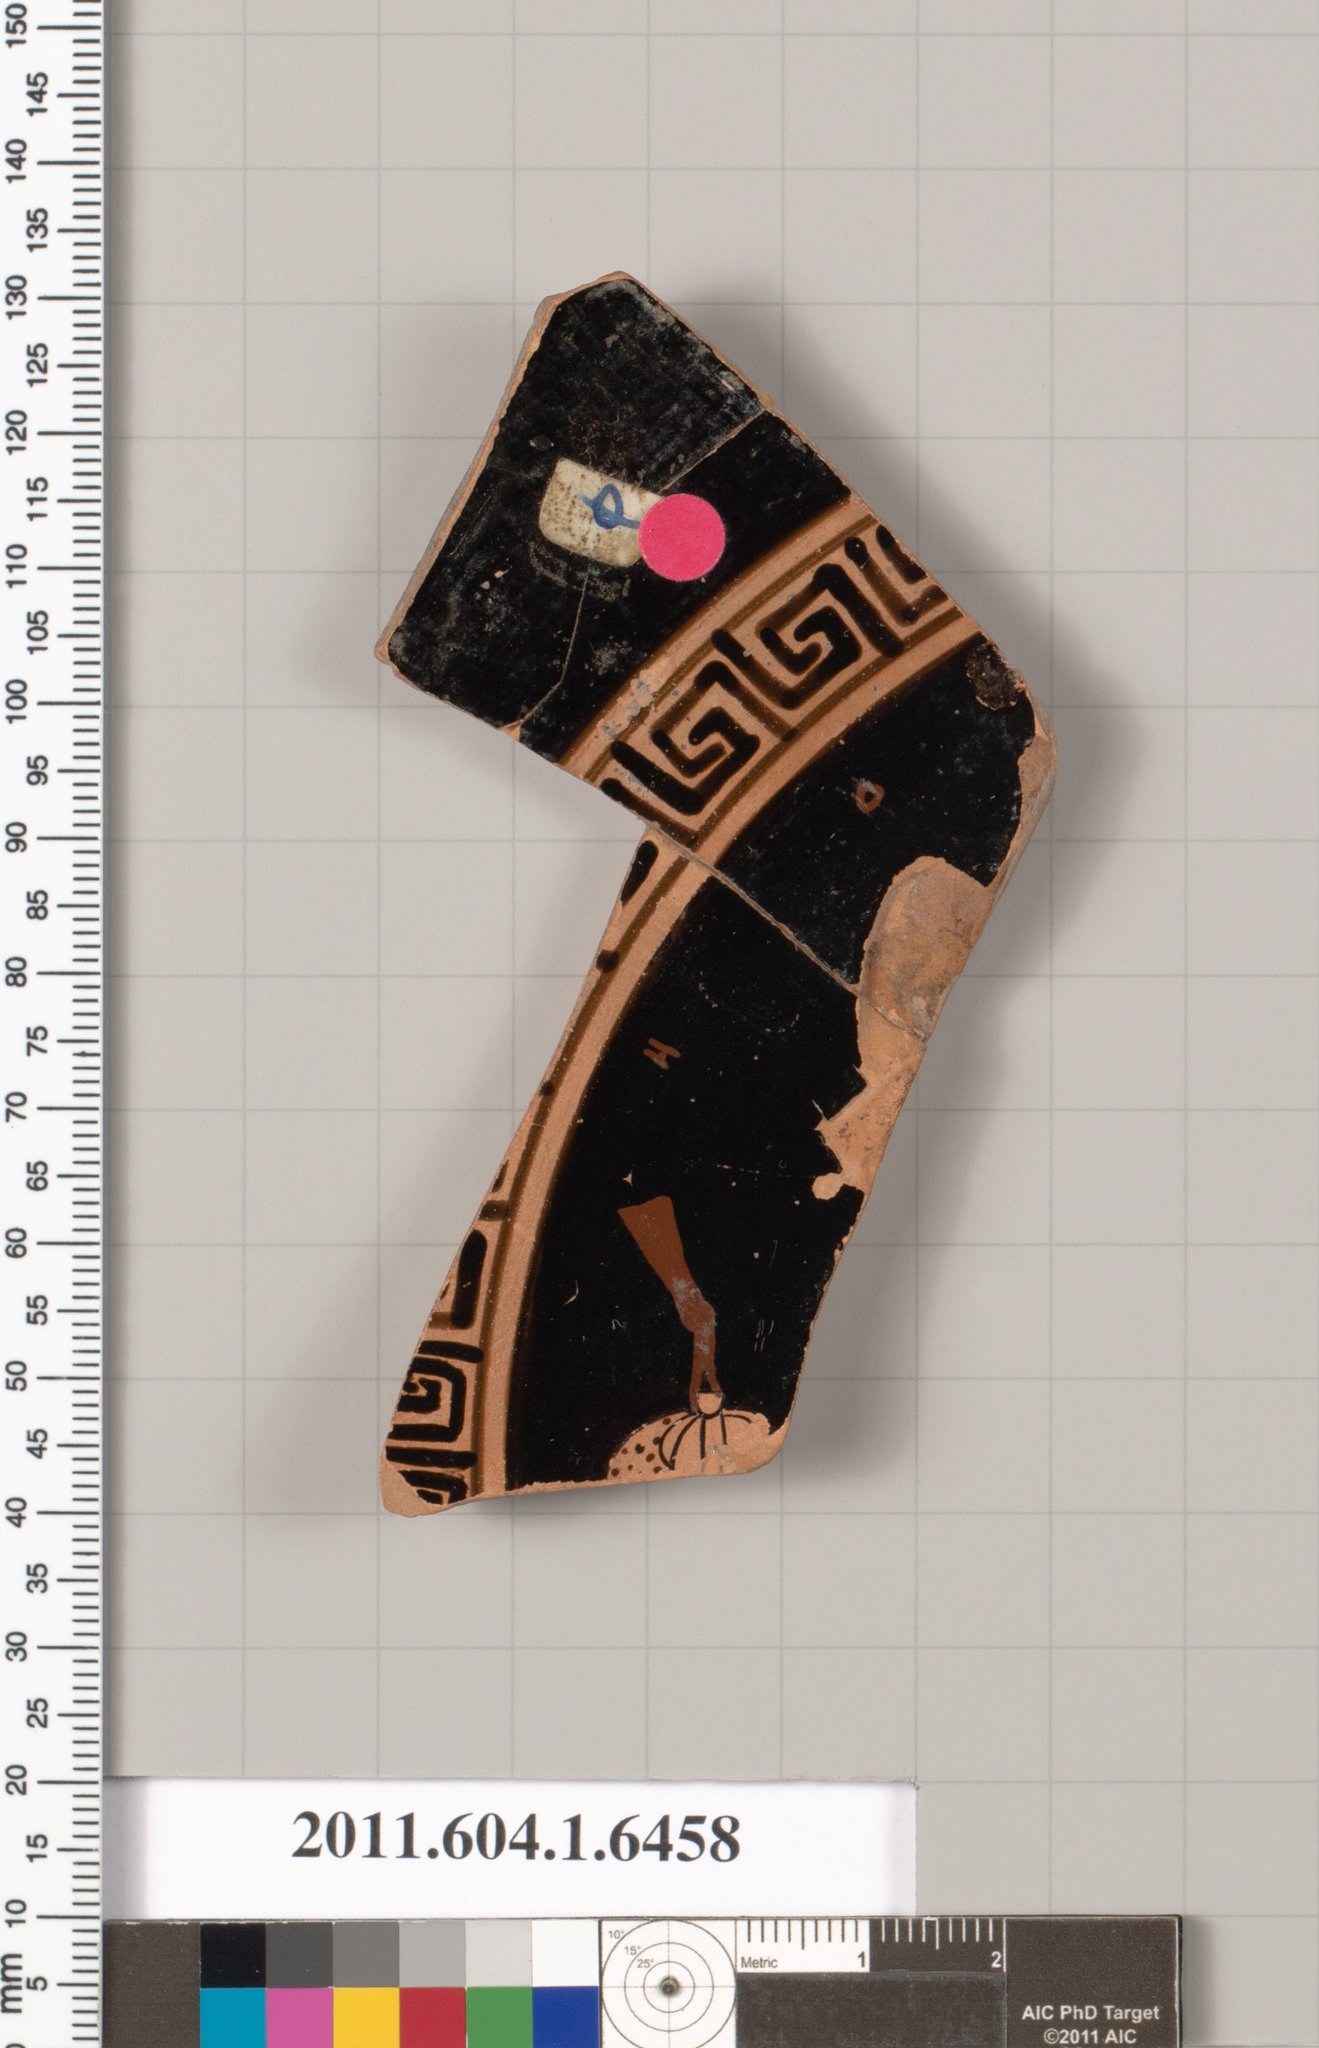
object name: kylix fragment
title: Terracotta fragment of a kylix (drinking cup)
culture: greek, attic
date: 490-480 BCE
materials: terracotta